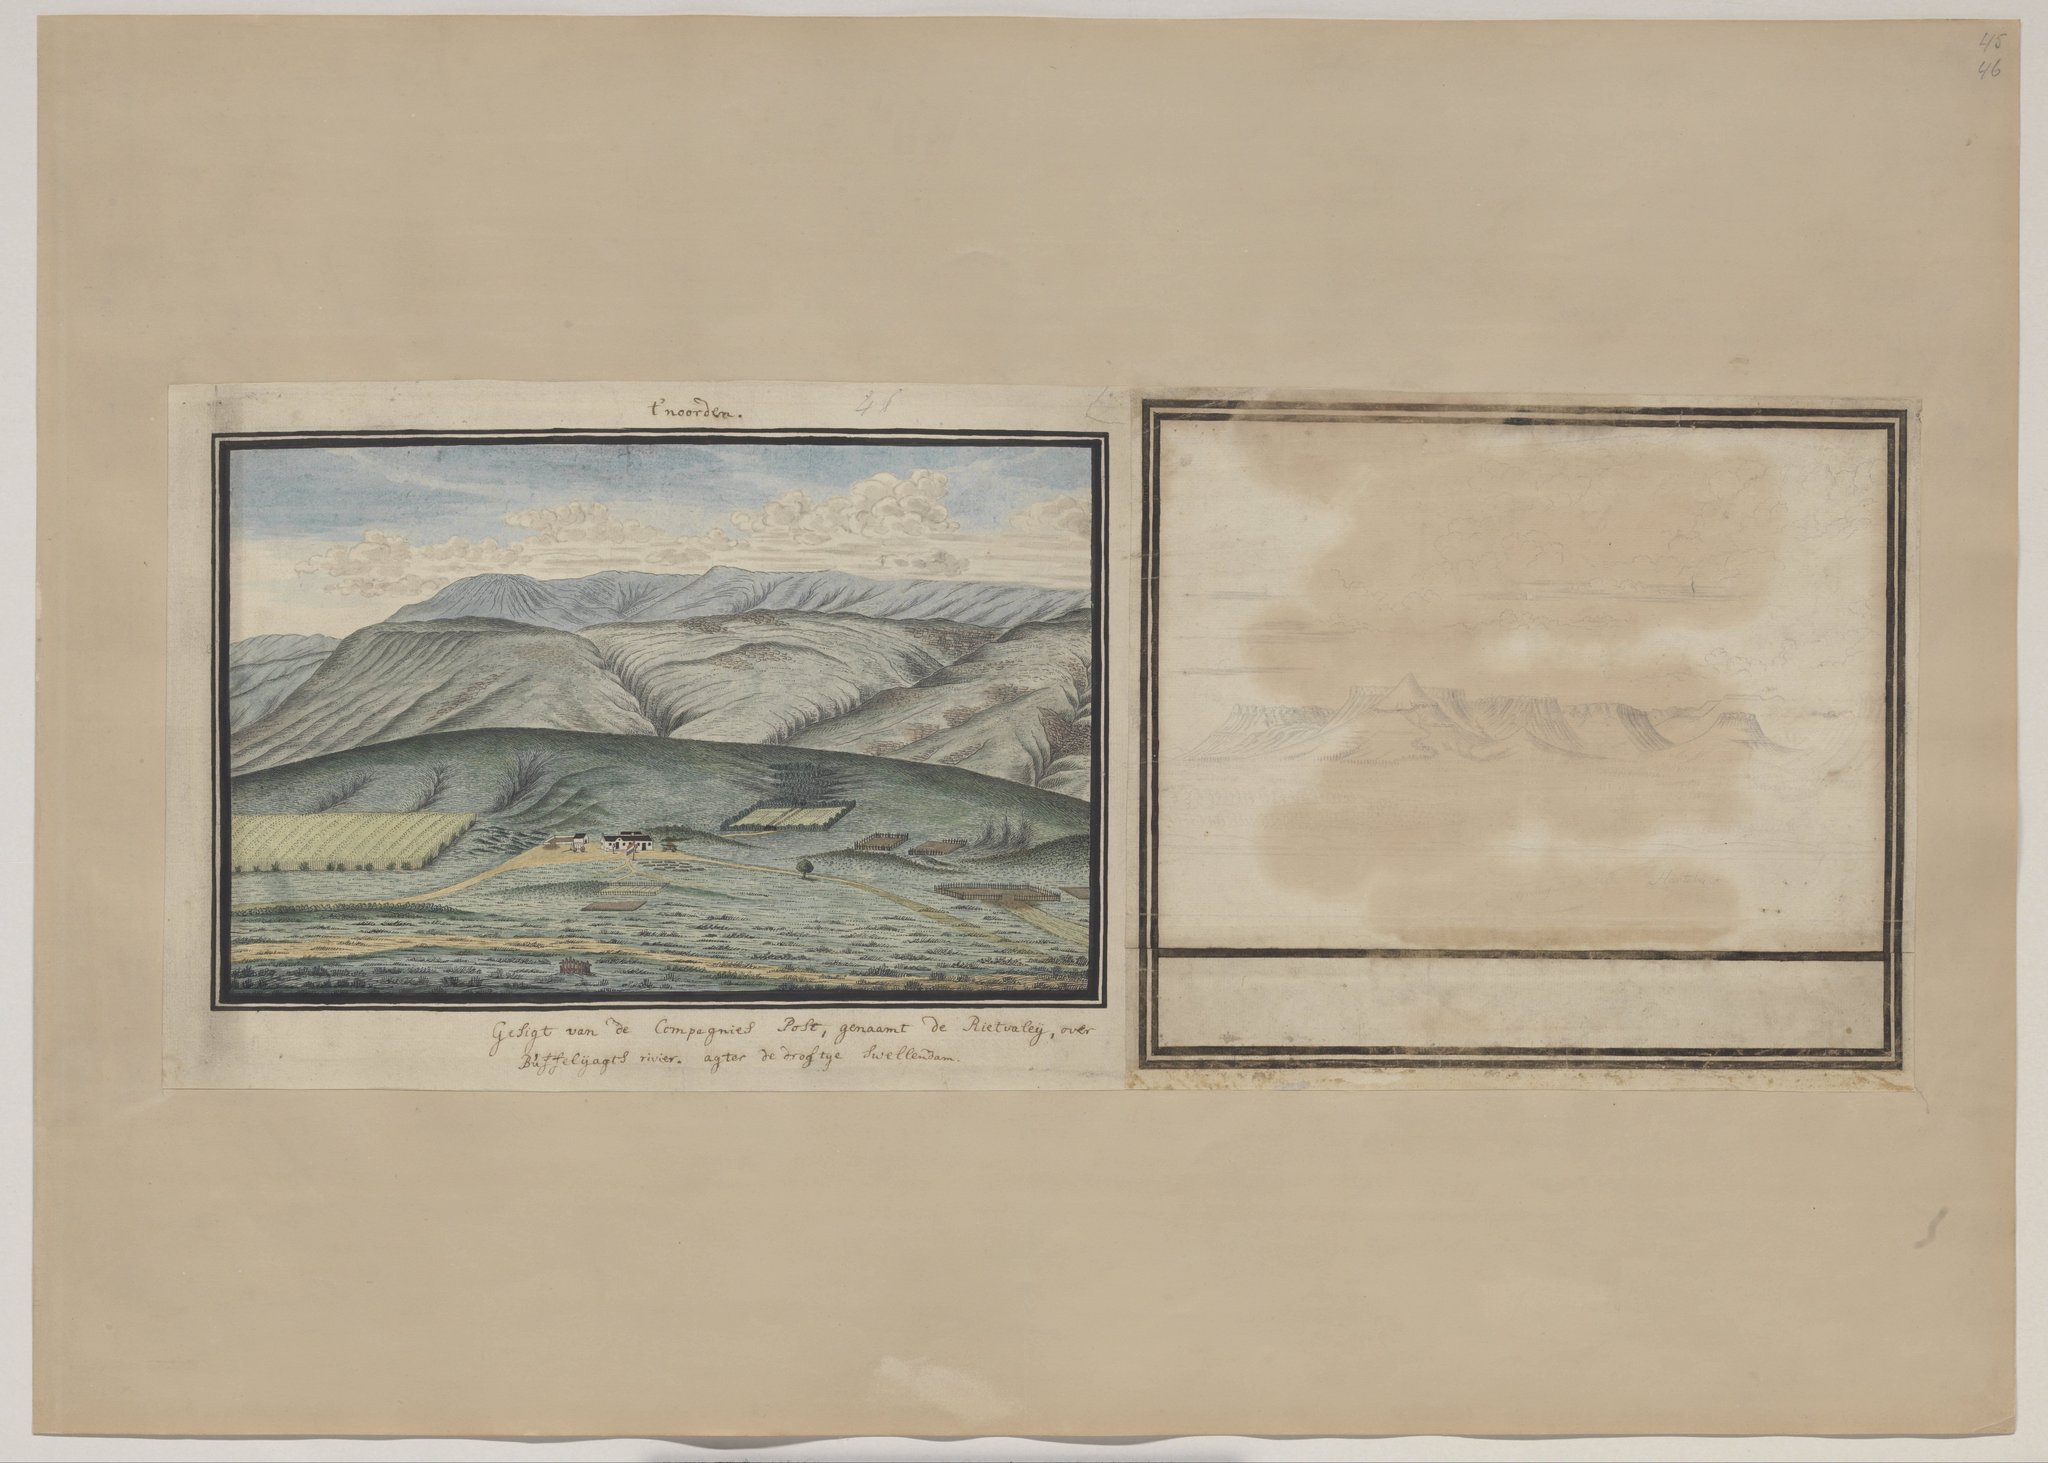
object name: panorama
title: View of the Vuilkop and the Perdeberd in Camdebo seen from the south east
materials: ink, paper, pencil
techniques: pen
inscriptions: annotation: ‘"Spring Bocke Jagt" en "Hartebeest"’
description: Oorspronkelijk in omslag van roodkleurig halfleer en roodgemarmerd plat, dorso met ribben en goudopdruk; 71 x 99 x 6 cm.